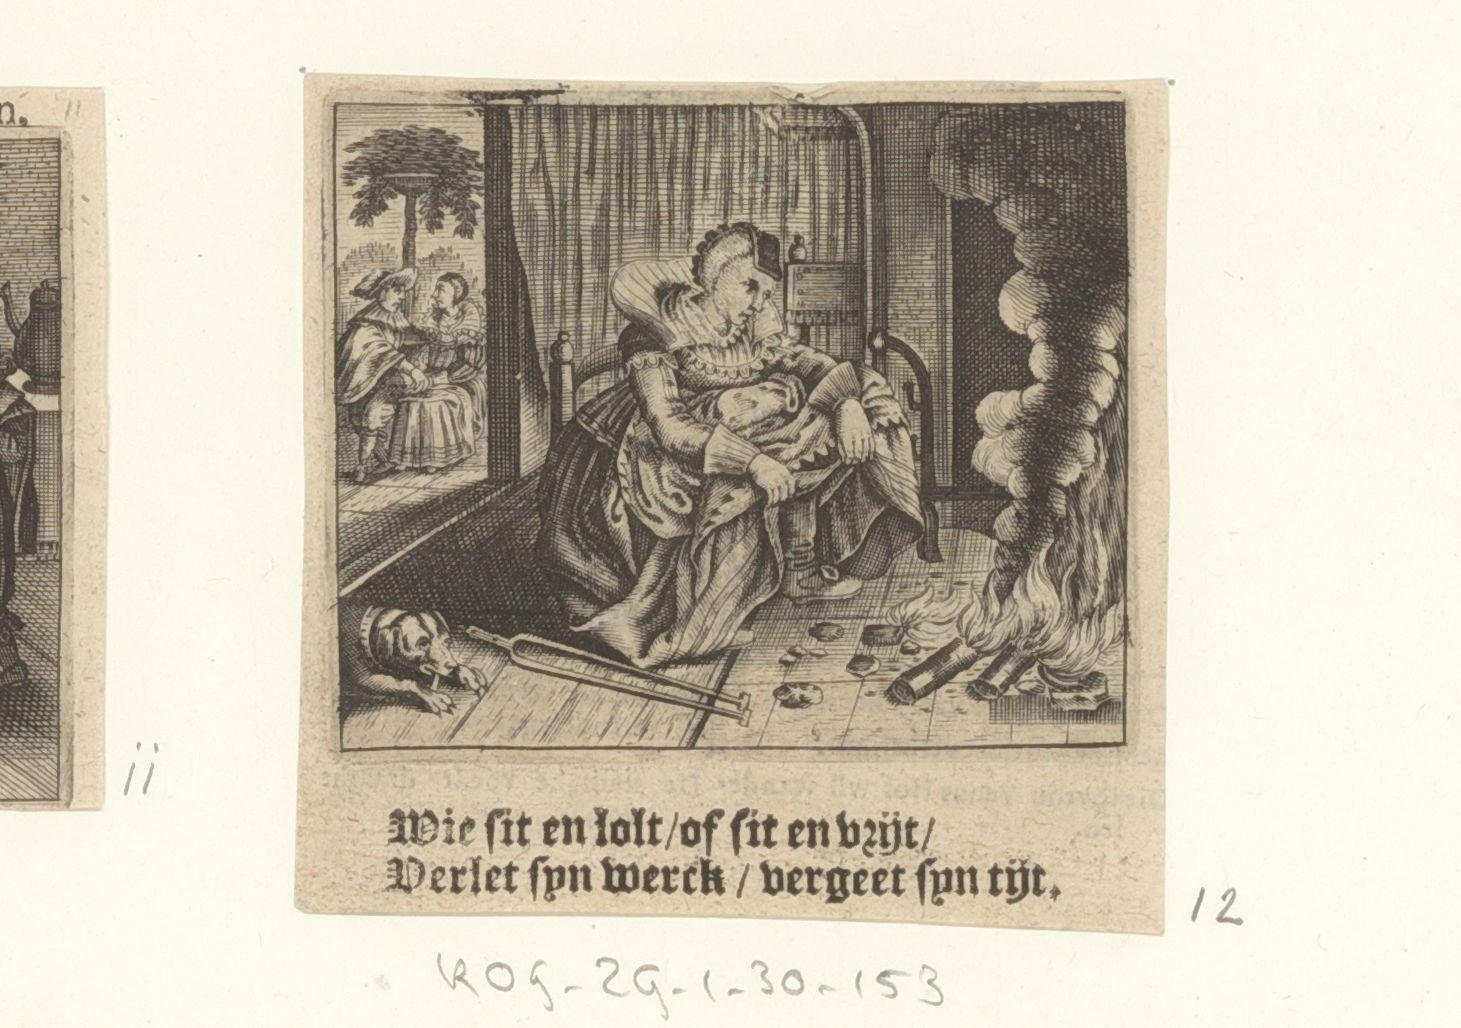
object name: book illustration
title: Wie sit en lolt / of sit en vrijt/ Velret syn werck / vergeet sijn tijt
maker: Anonymous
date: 1635-1715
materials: paper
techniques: engraving, letterpress printing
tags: warming oneself at a fire (or hearth, stove, fire-pan, brazier), open hearth, fire-place, skirt, proverbs, sayings, etc.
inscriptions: stamp, collector's mark: Lugt 1641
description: Veel versies van dit embleem verschenen in verschillende uitgave van Spiegel van den Ouden ende Nieuwen Tydt. Zoals: Cats, Jacob. Spiegel van den Ouden ende Nieuwen-tijt, Bestaende uyt Spreeck-woorden (...). Dordrecht: Jacob Braat, 1647. Maar ook in andere publicaties (1665, 1671, 1715, 1722).